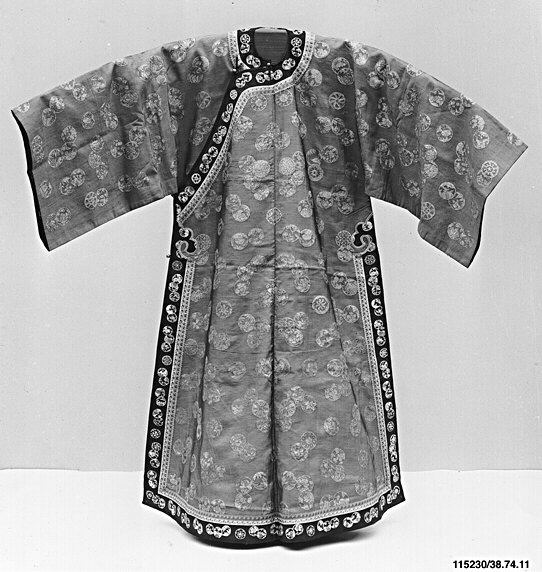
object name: woman's robe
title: Women's Tapestry-Woven (Kesi) Robe with Roundels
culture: chinese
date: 1701-1800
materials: metal thread, silk